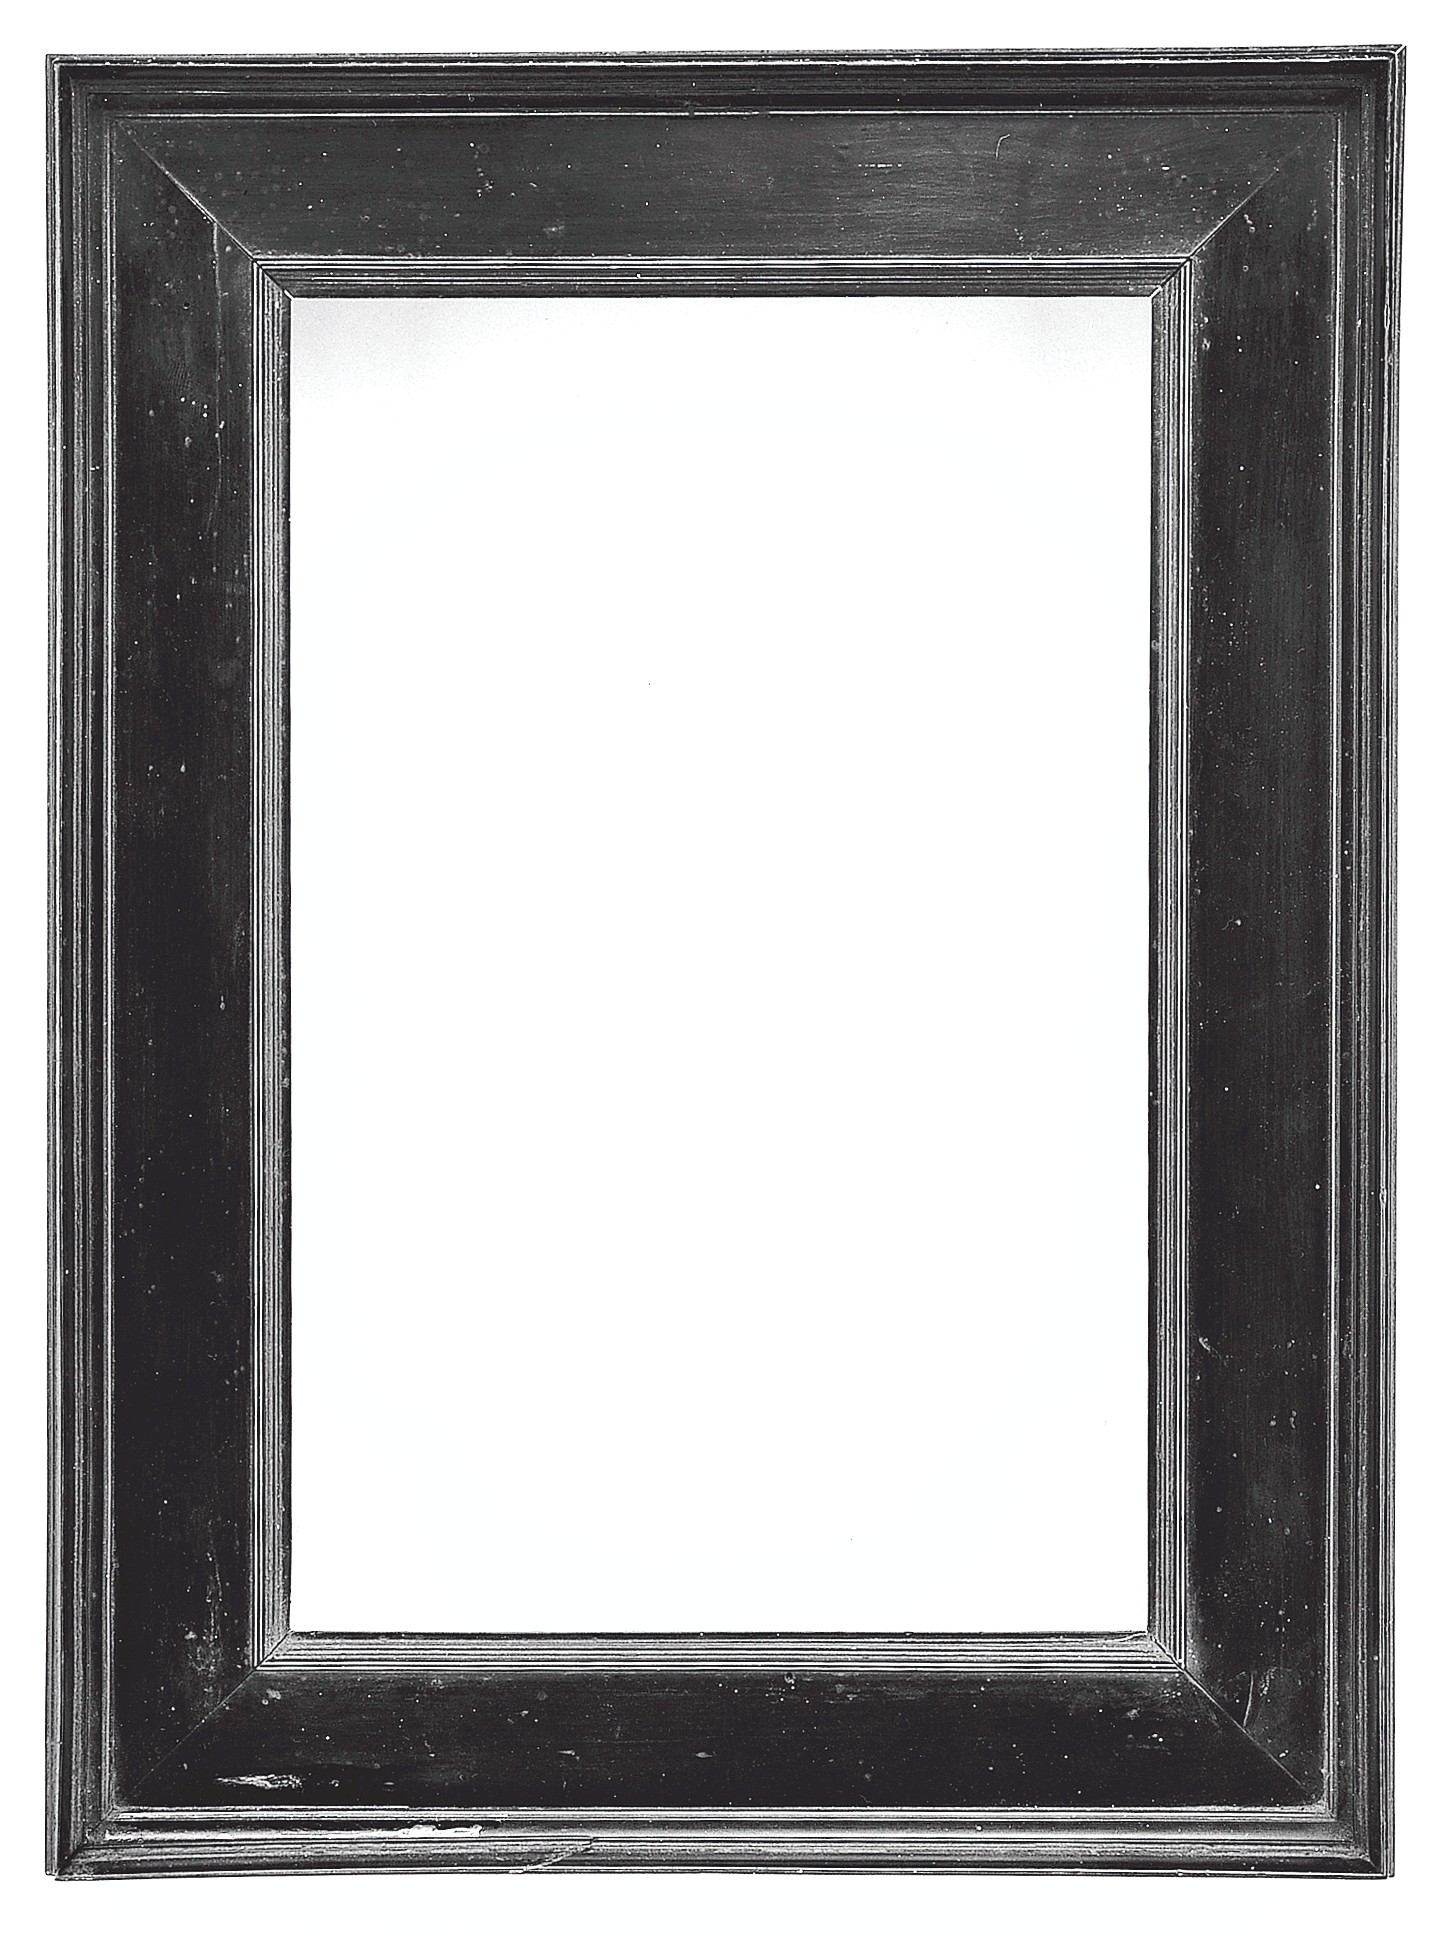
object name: frame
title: Cassetta frame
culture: italian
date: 1590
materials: wood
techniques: polish